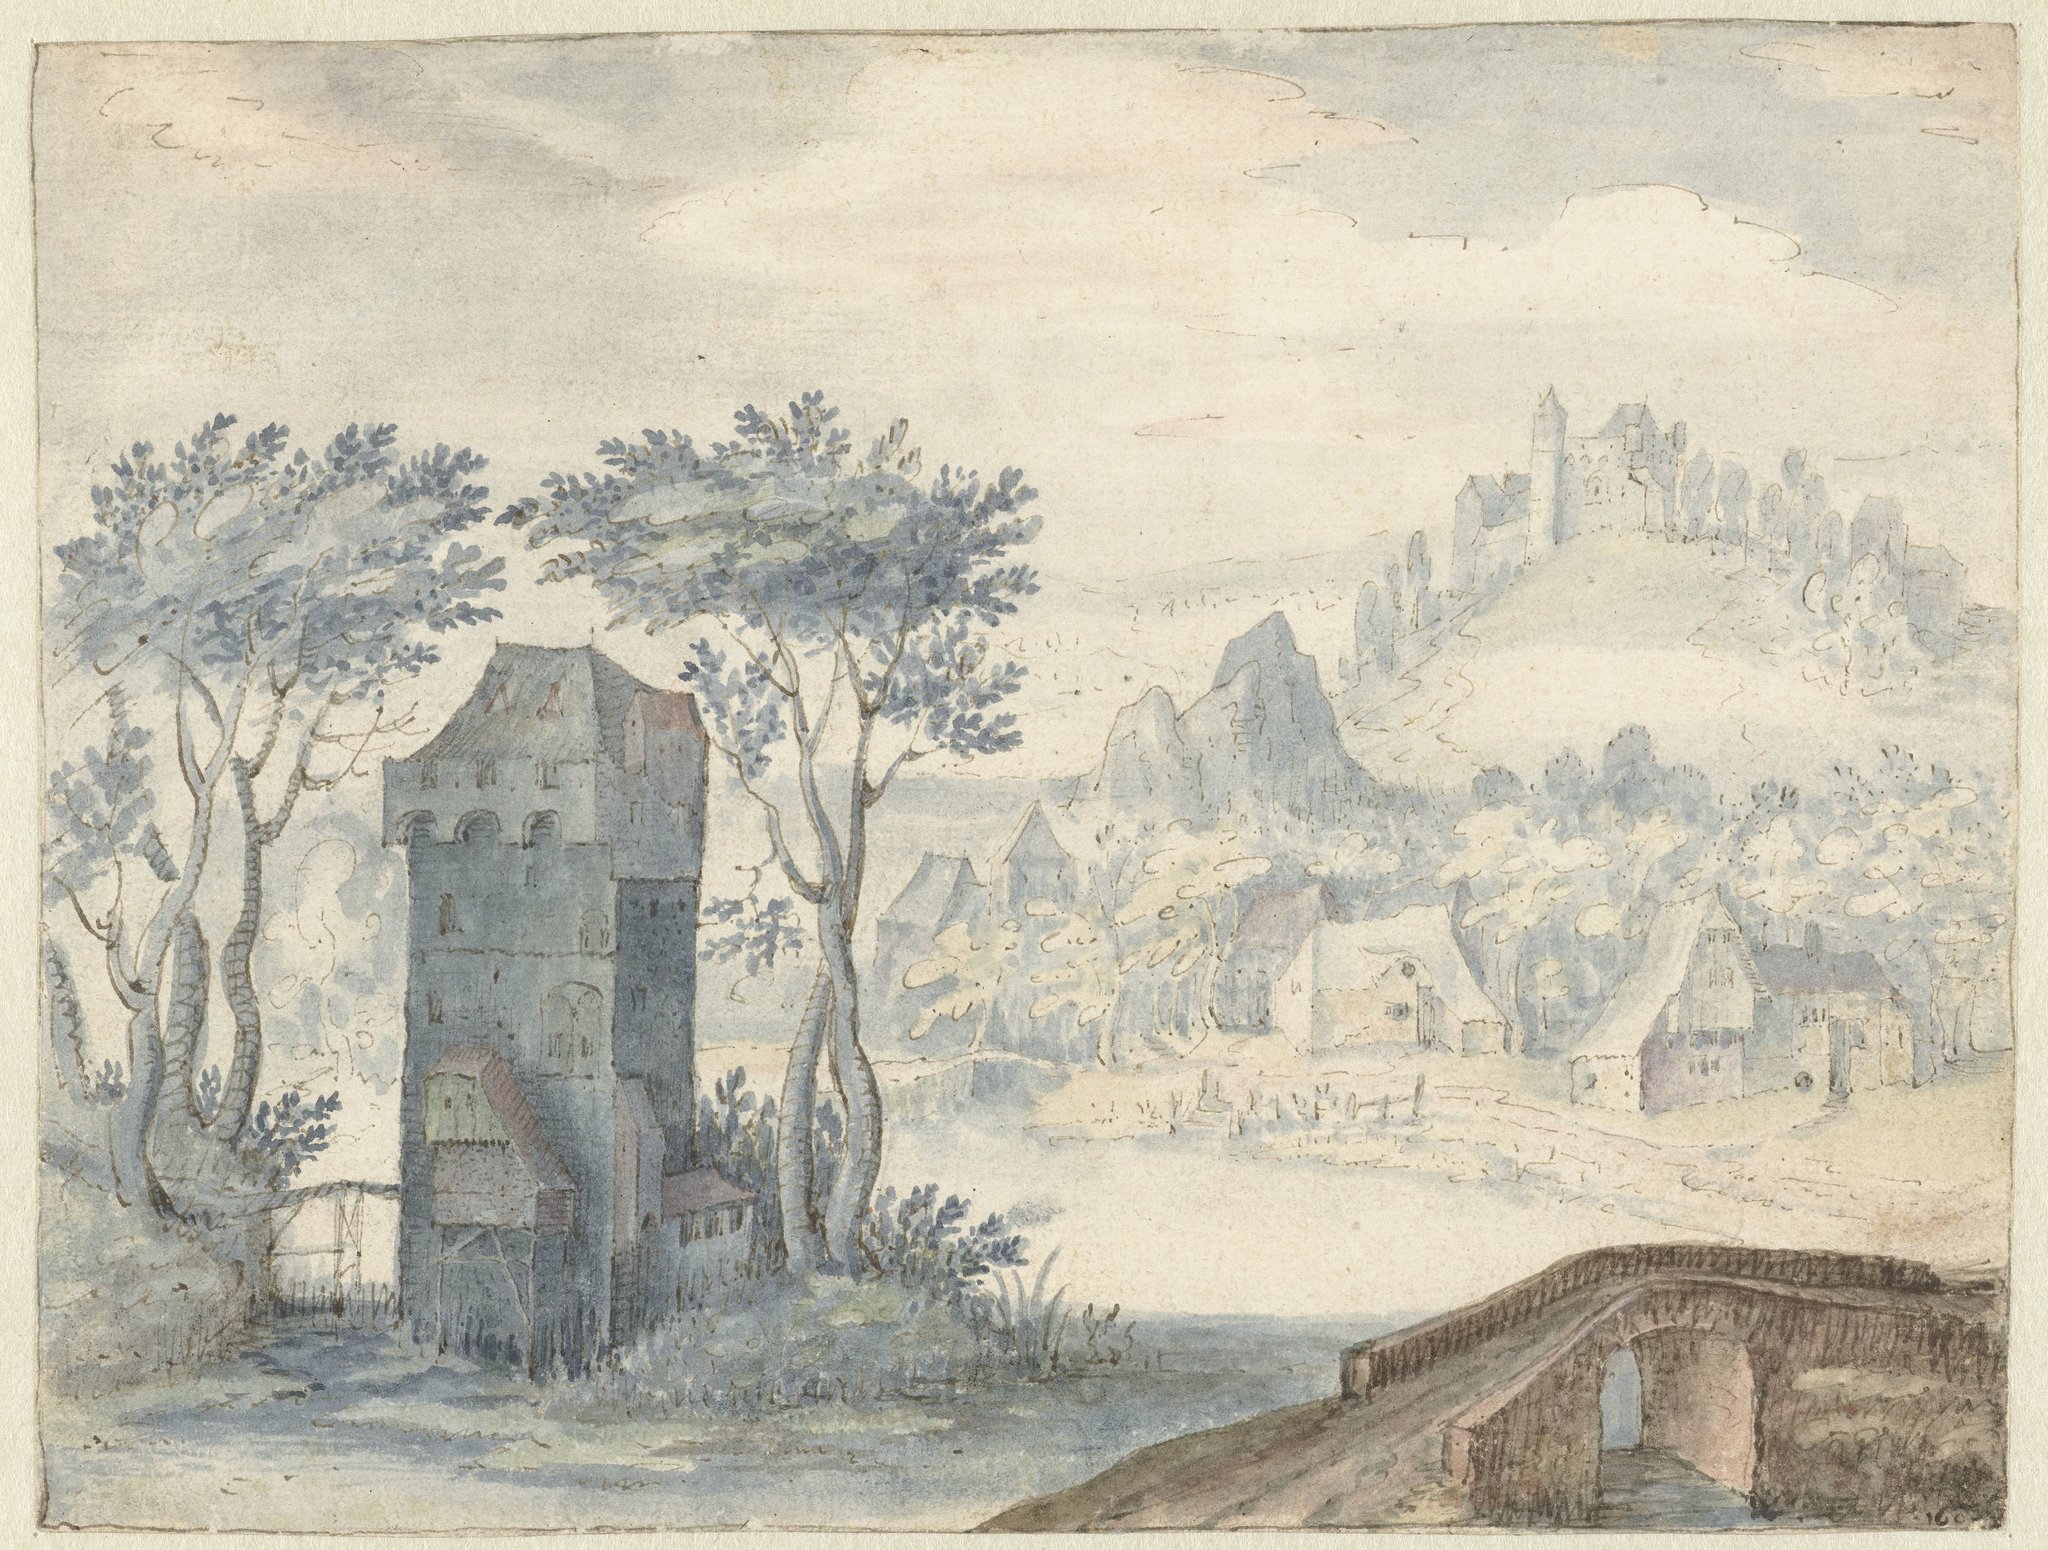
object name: drawing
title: Landschap met toren tussen bomen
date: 1554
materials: ink, paper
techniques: brush, pen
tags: landscape with bridge, viaduct or aqueduct, landscape with tower or castle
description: Landschap met een toren tussen bomen en rechts op de voorgrond een bruggetje.